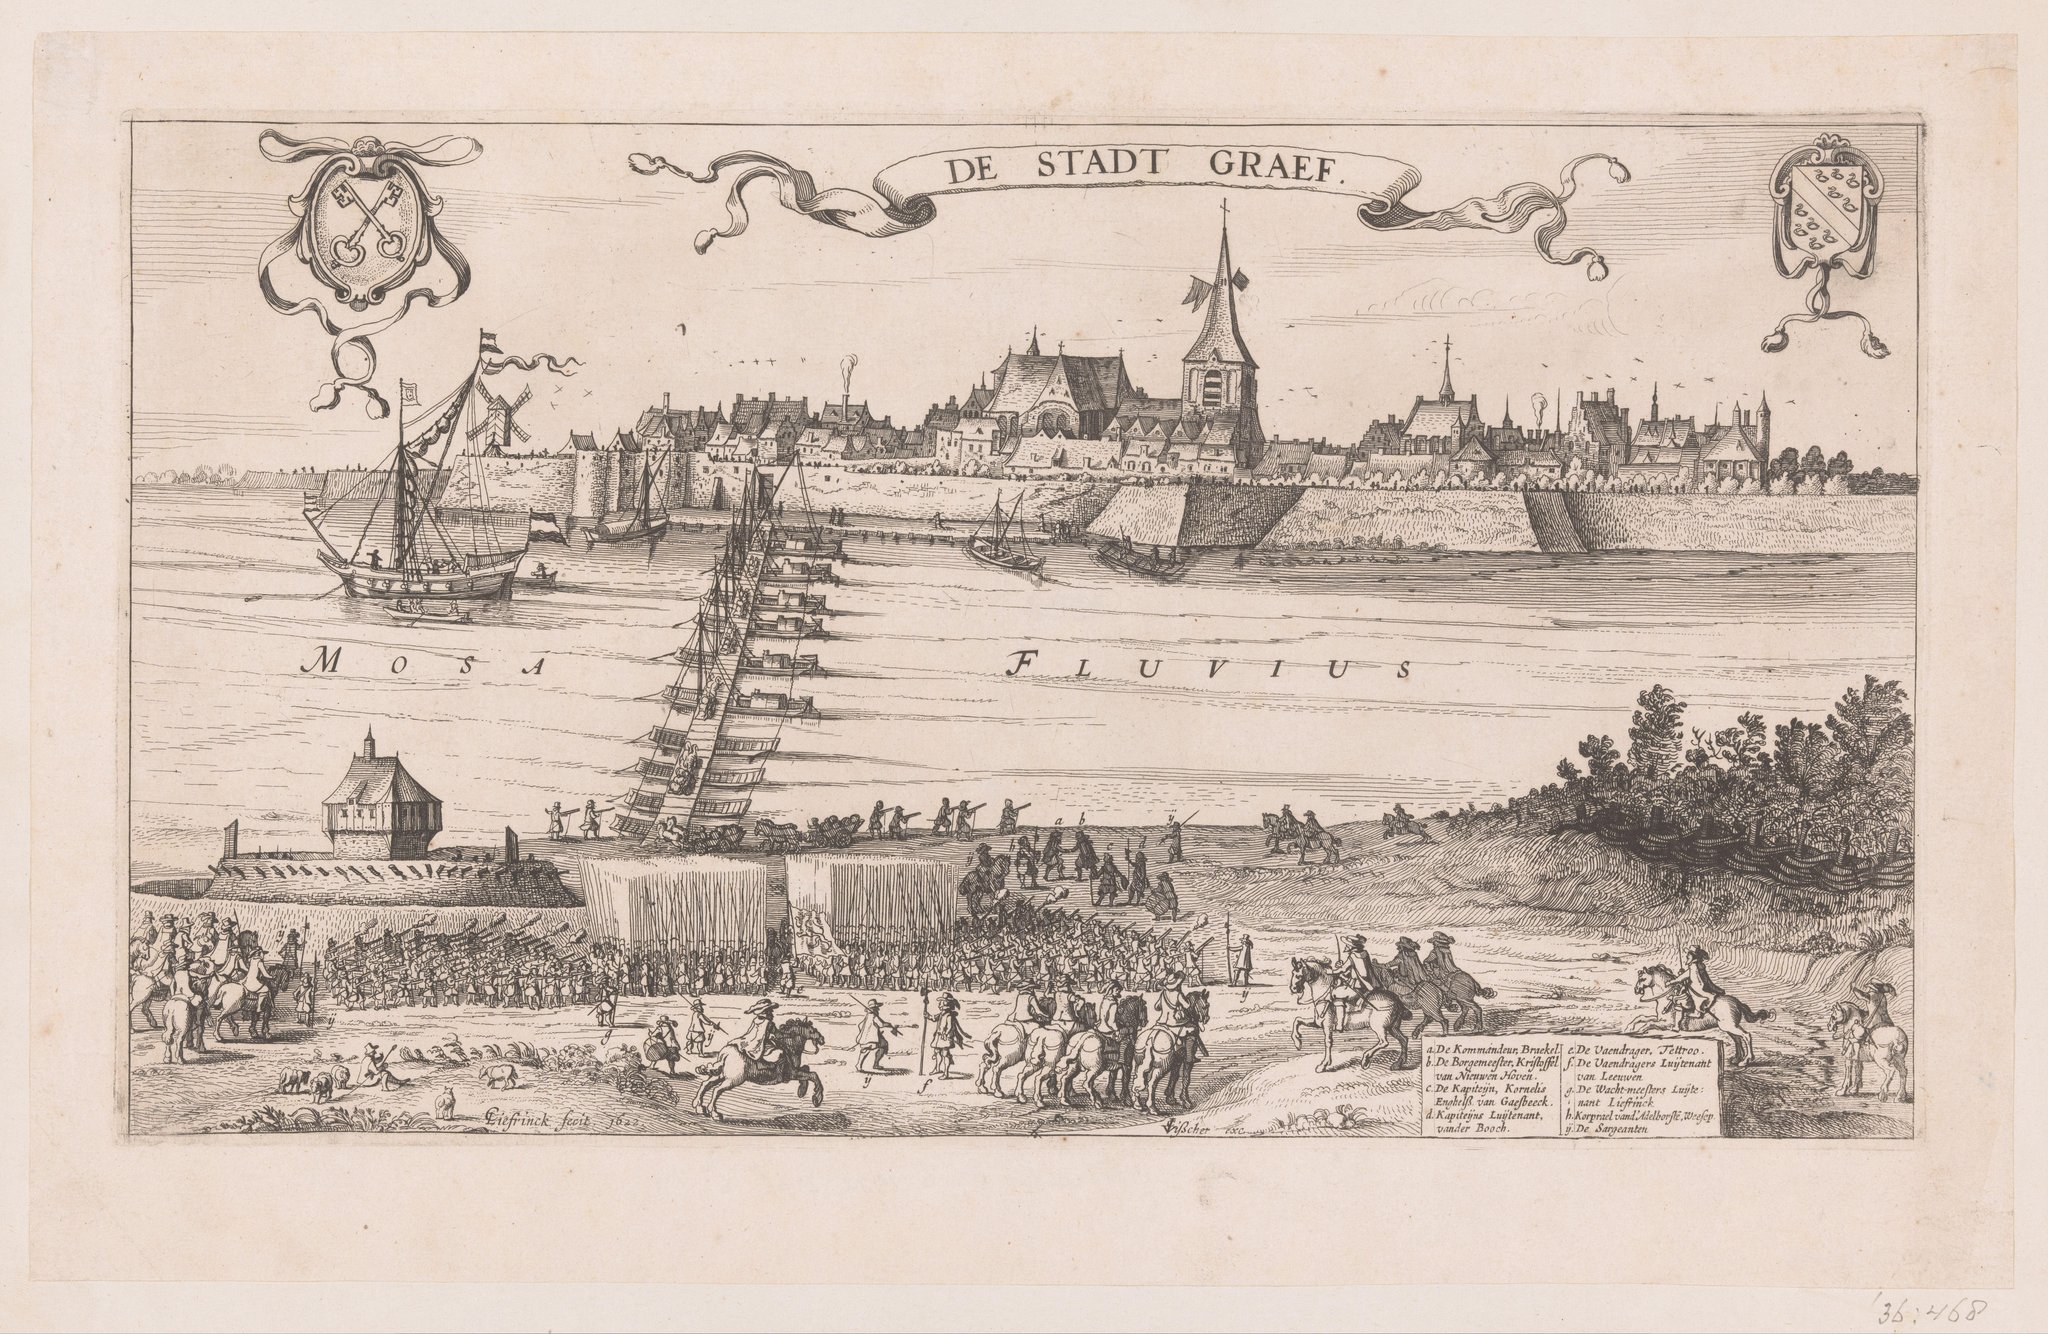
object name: print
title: Aankomst van de schutterij van Leiden in Grave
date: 1622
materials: paper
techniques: etching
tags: siege, grave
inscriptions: collector's mark: Lugt 2228, collector's mark: Lugt 2760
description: De aankomst van de Leidse schutterij bij Grave, 26 september 1622. De troepen verzamelen zich aan de oever van de Maas bij de schipbrug. Onderaan de legenda a-ij. Boven in de lucht de wapens van Leiden en Grave. Onderdeel van een serie van 3 prenten van de tocht van de schutterij van Leiden naar Grave om de stad bezet te houden zodat Maurits ter ontzet naar Bergen op Zoom op kan trekken.